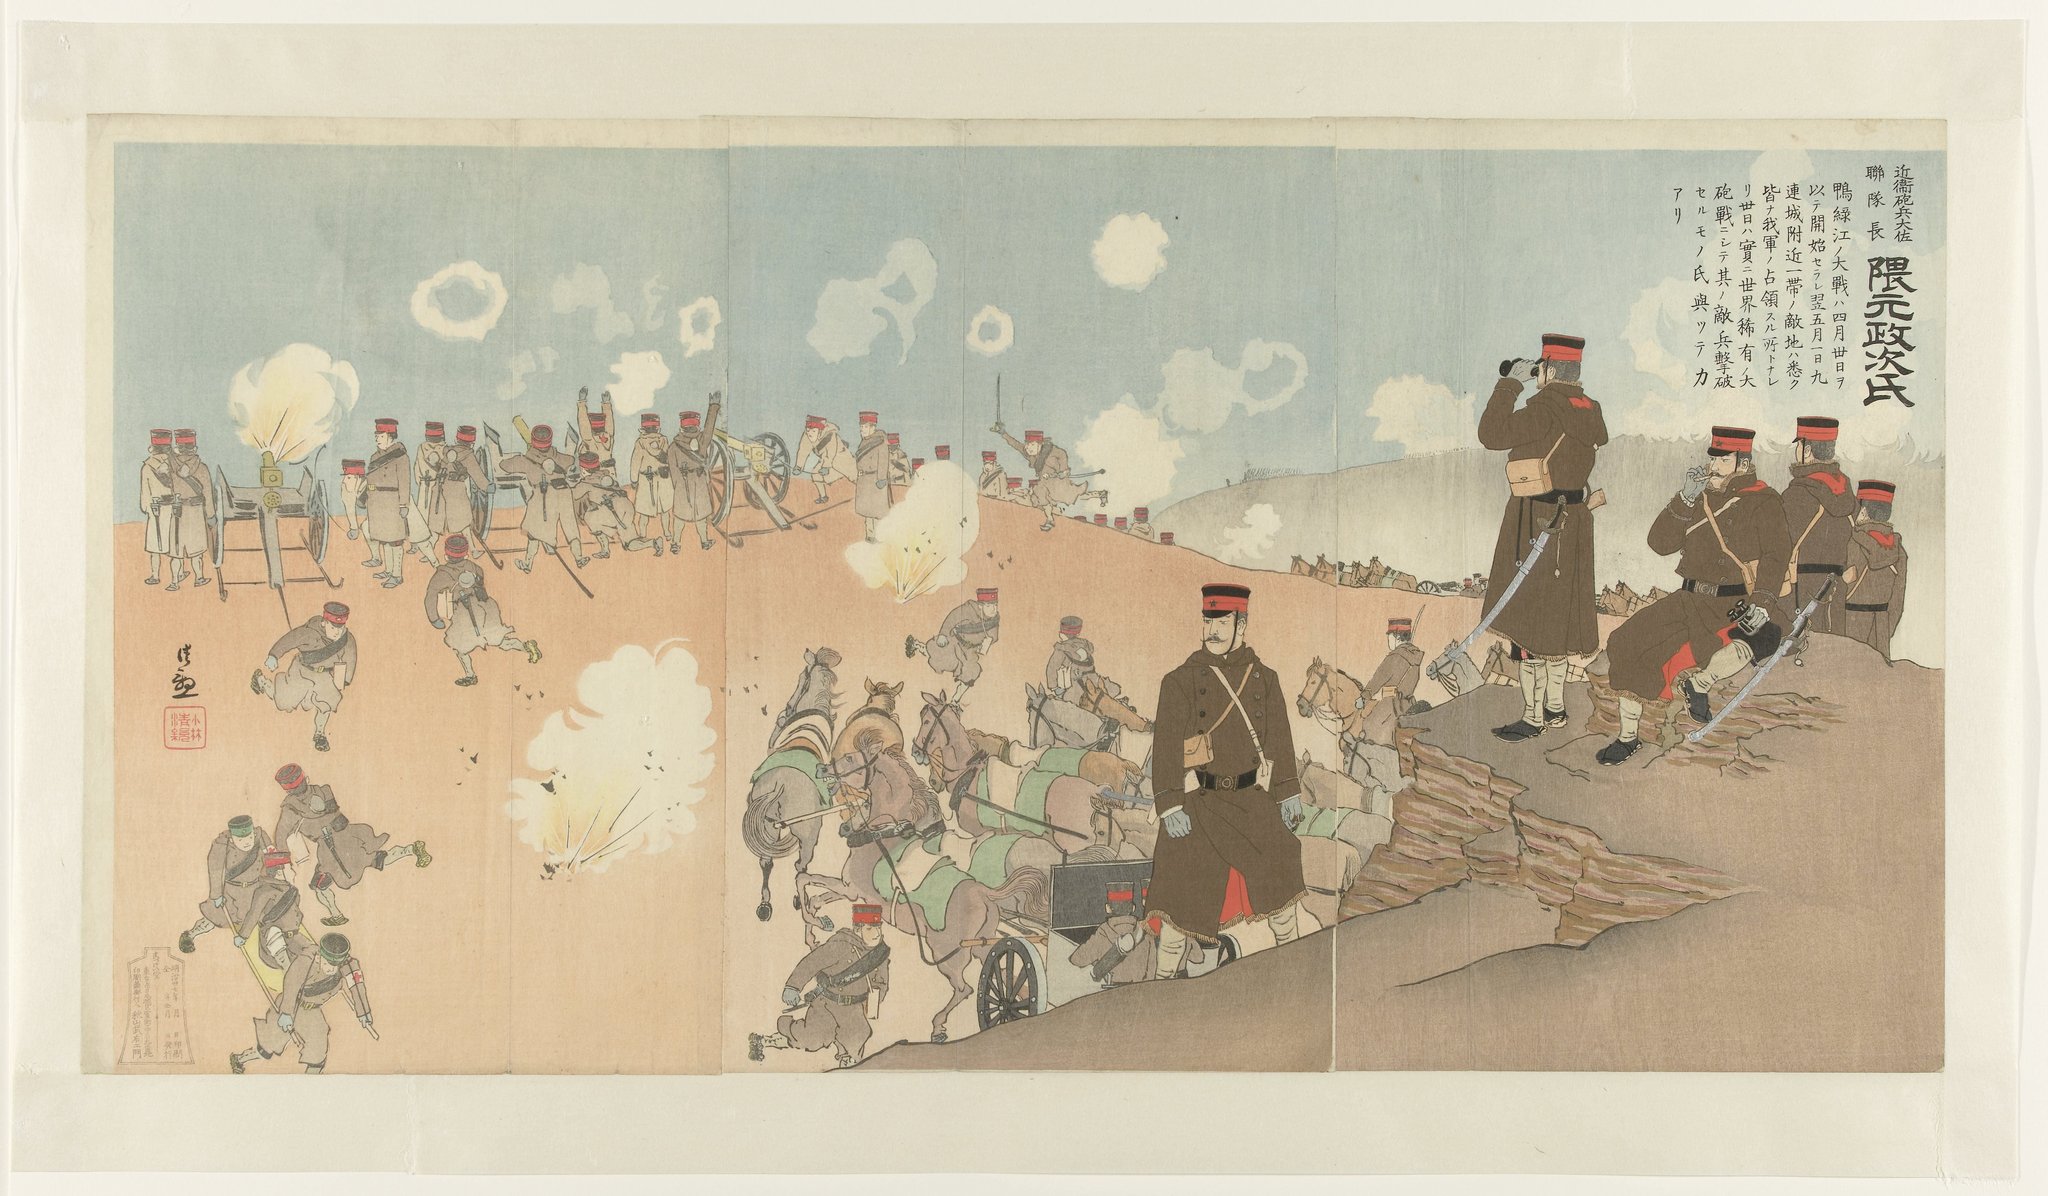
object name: print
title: Konoe hôhei taisa rentaichô Kumamoto Masaji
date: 1904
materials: paper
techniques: woodcut, polish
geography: japan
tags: battle, firearms: cannon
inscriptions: collector's mark: Lugt 2228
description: Japanse soldaten staan met kanonnen op een heuvel tijdens de Slag om de Yalu rivier tijdens de Russisch-Japanse Oorlog (1904-1905).Het gevecht duurde slechts een dag, van 30 april tot 1 mei 1904 en werd gewonnen door het Japanse leger.